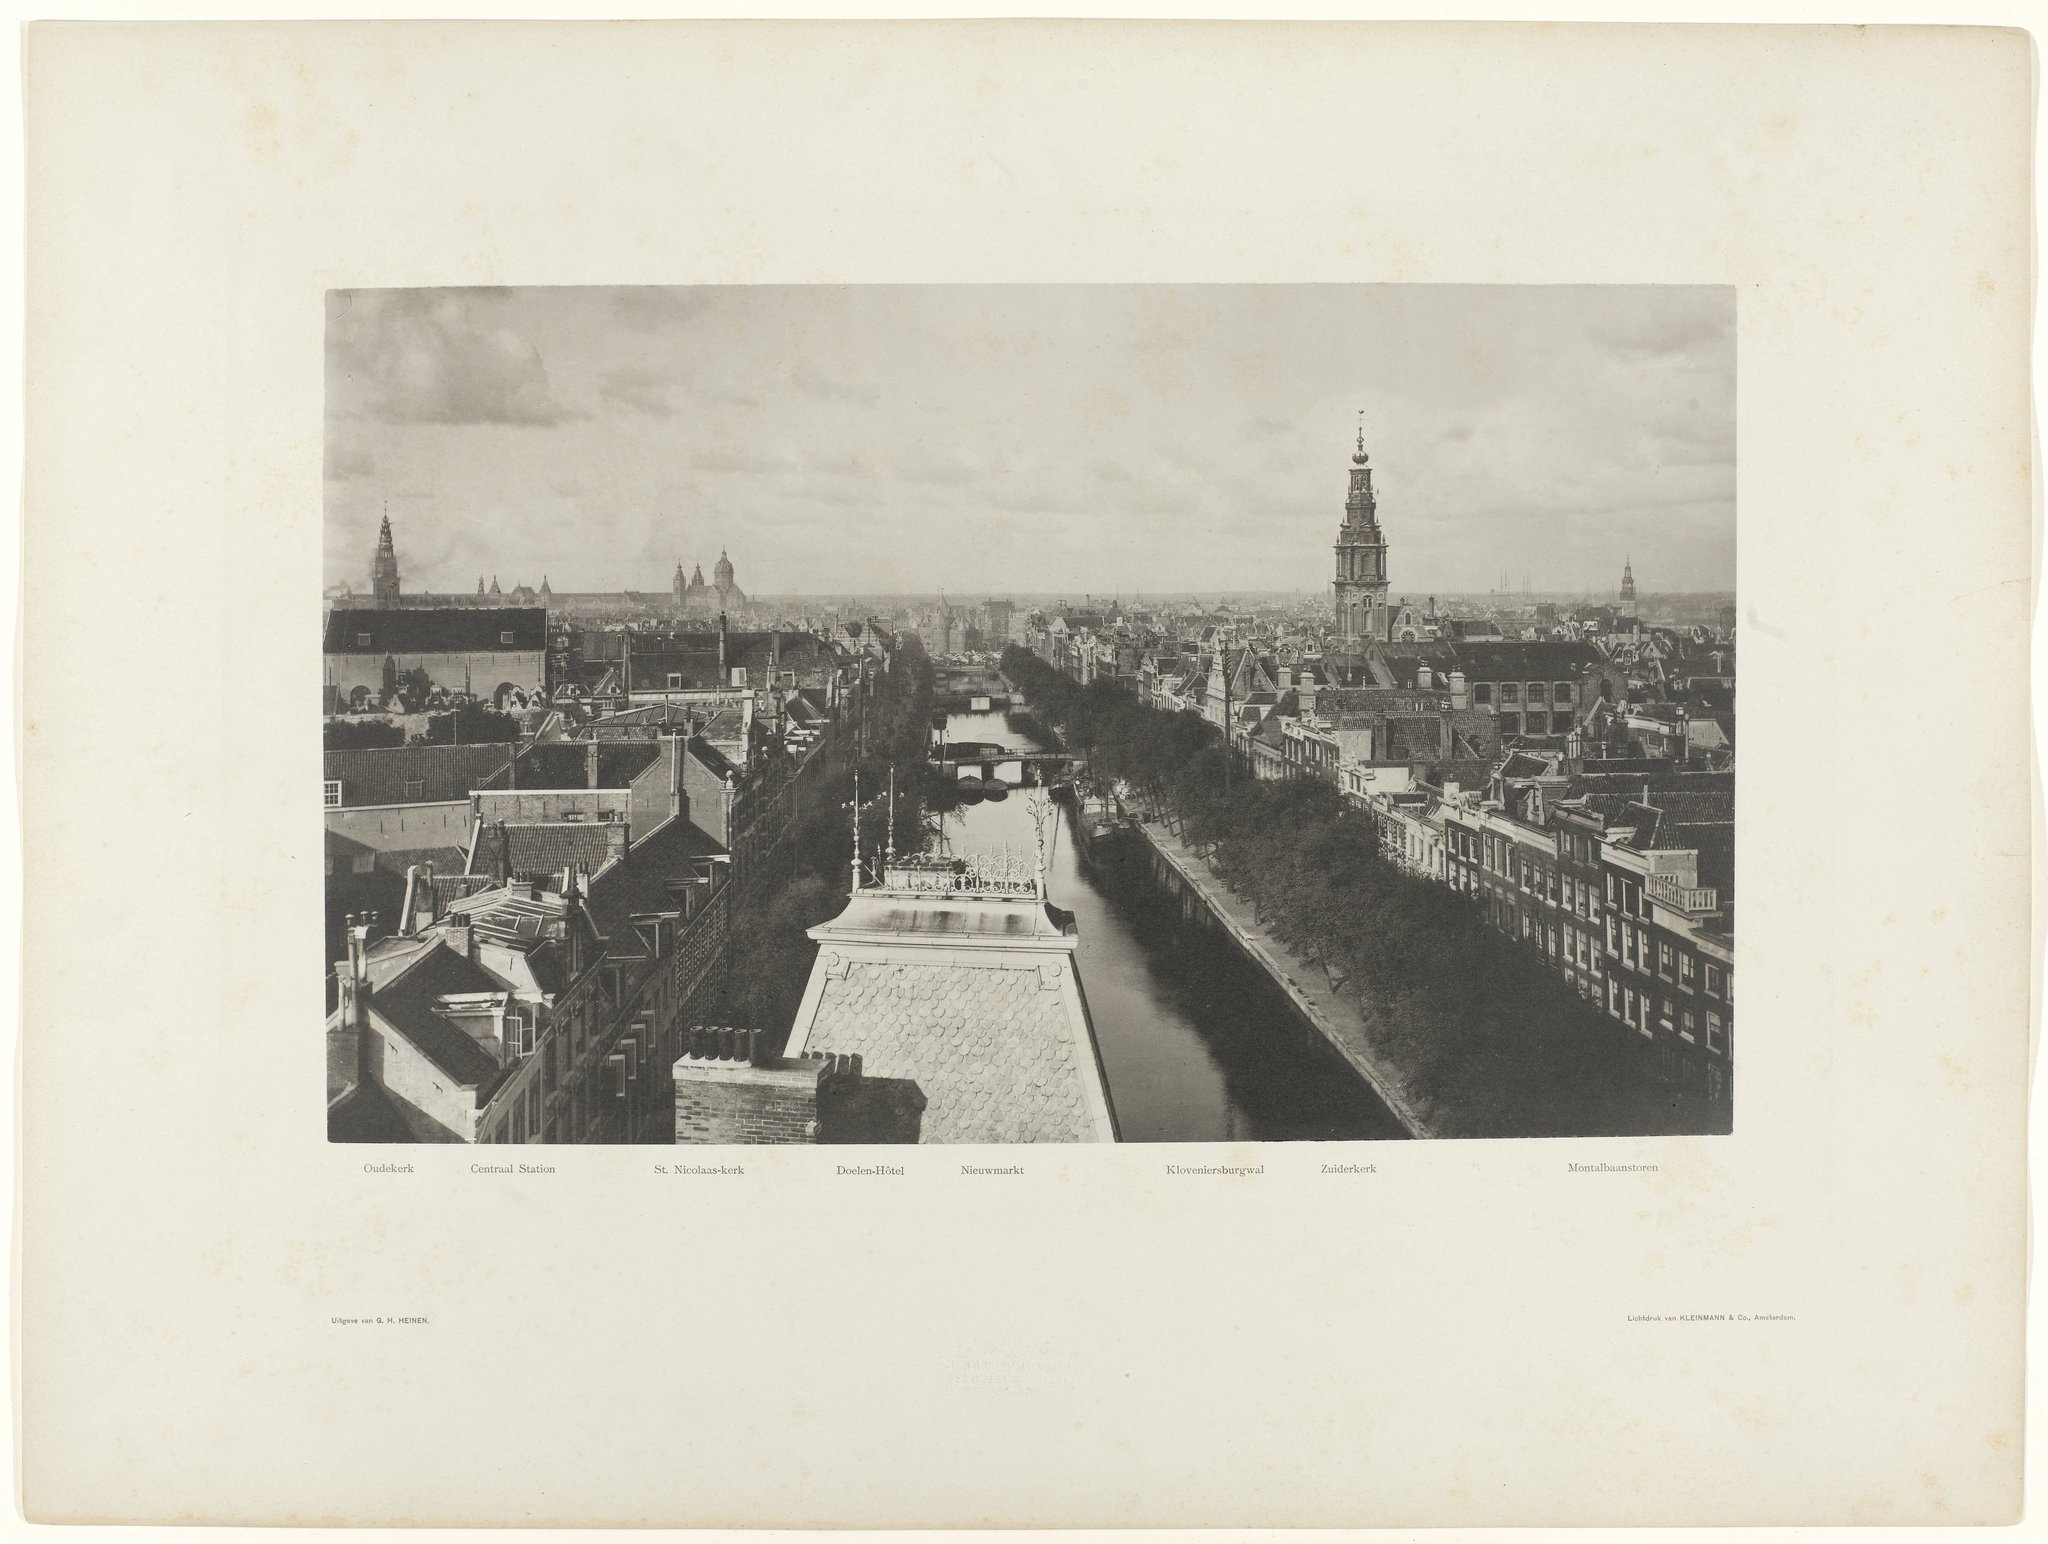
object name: photomechanical print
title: Kloveniersburgwal, seen from the Doelen Hotel Amsteldijk at the Ceintuurbaan, seen from a house on Amsteldijk 42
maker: gerrit hendricus heinen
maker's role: painter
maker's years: 1851-1930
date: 1895-1898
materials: paper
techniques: photograph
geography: amsterdam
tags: city-view in general; 'veduta', canals, waters (in city)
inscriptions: check stamp: ‘G.H. Heinen Amsterdam/ Schilder & Fotograaf’